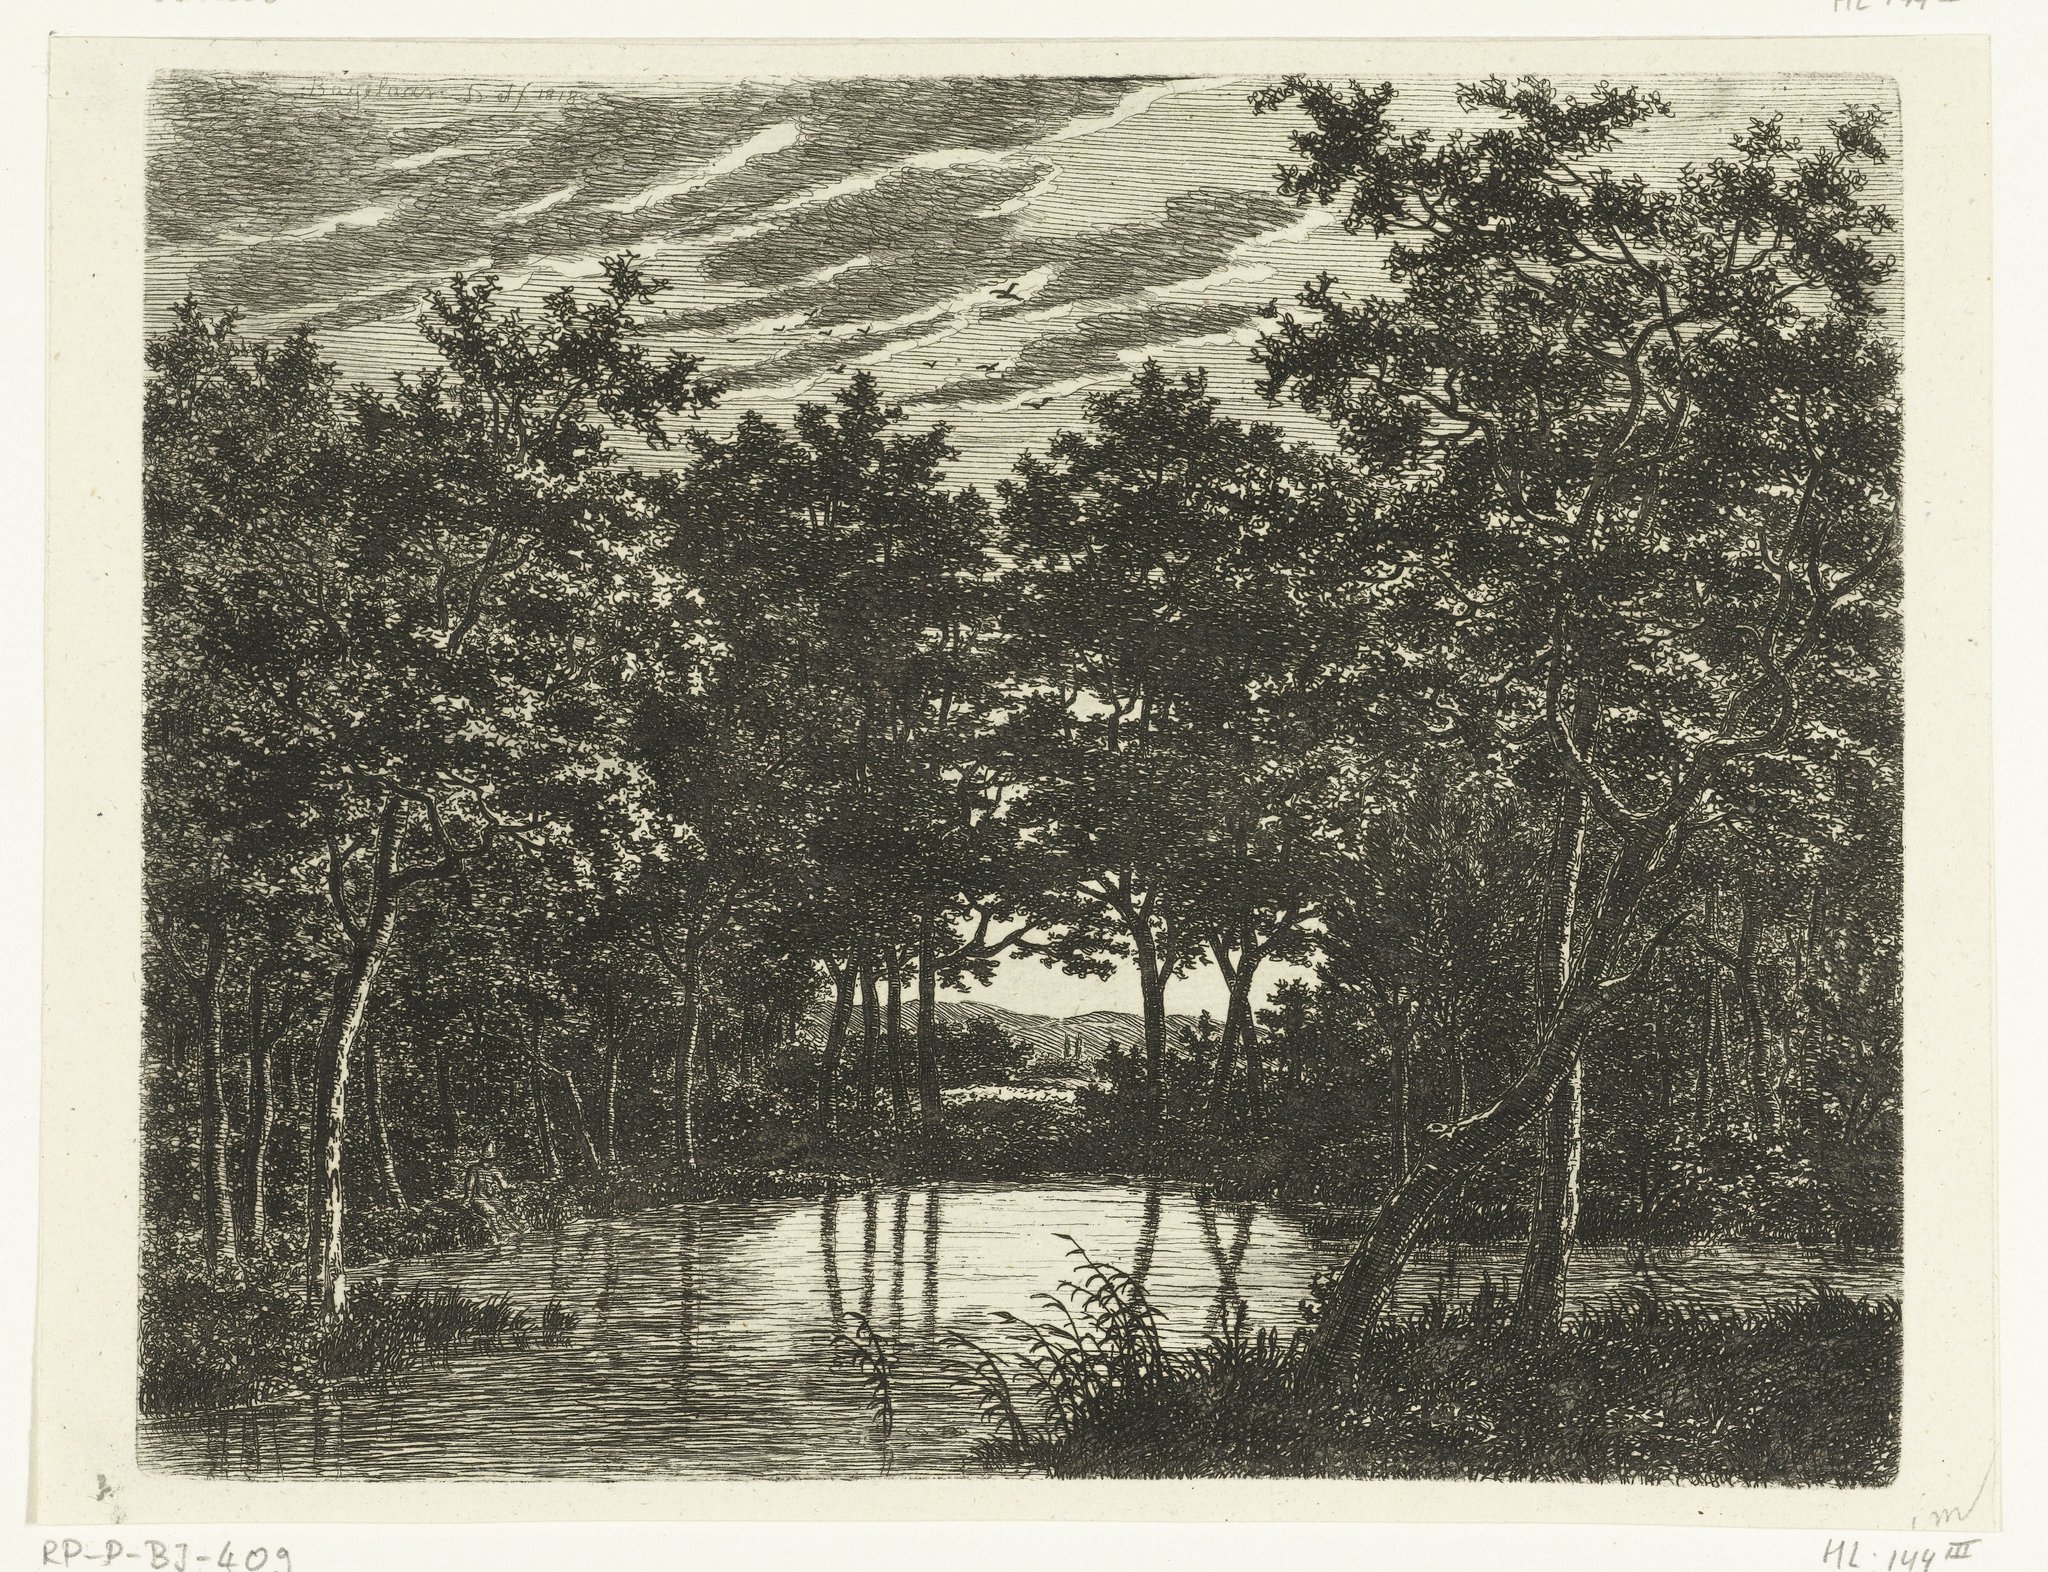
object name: print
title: Landschap met vijver, links zit een visser met een puntige hoed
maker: ernst willem jan bagelaar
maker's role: draughtsman, print maker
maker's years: 1775-1837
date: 1818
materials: paper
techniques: drypoint, etching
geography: netherlands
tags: pond, pool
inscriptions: collector's mark: Lugt 2228